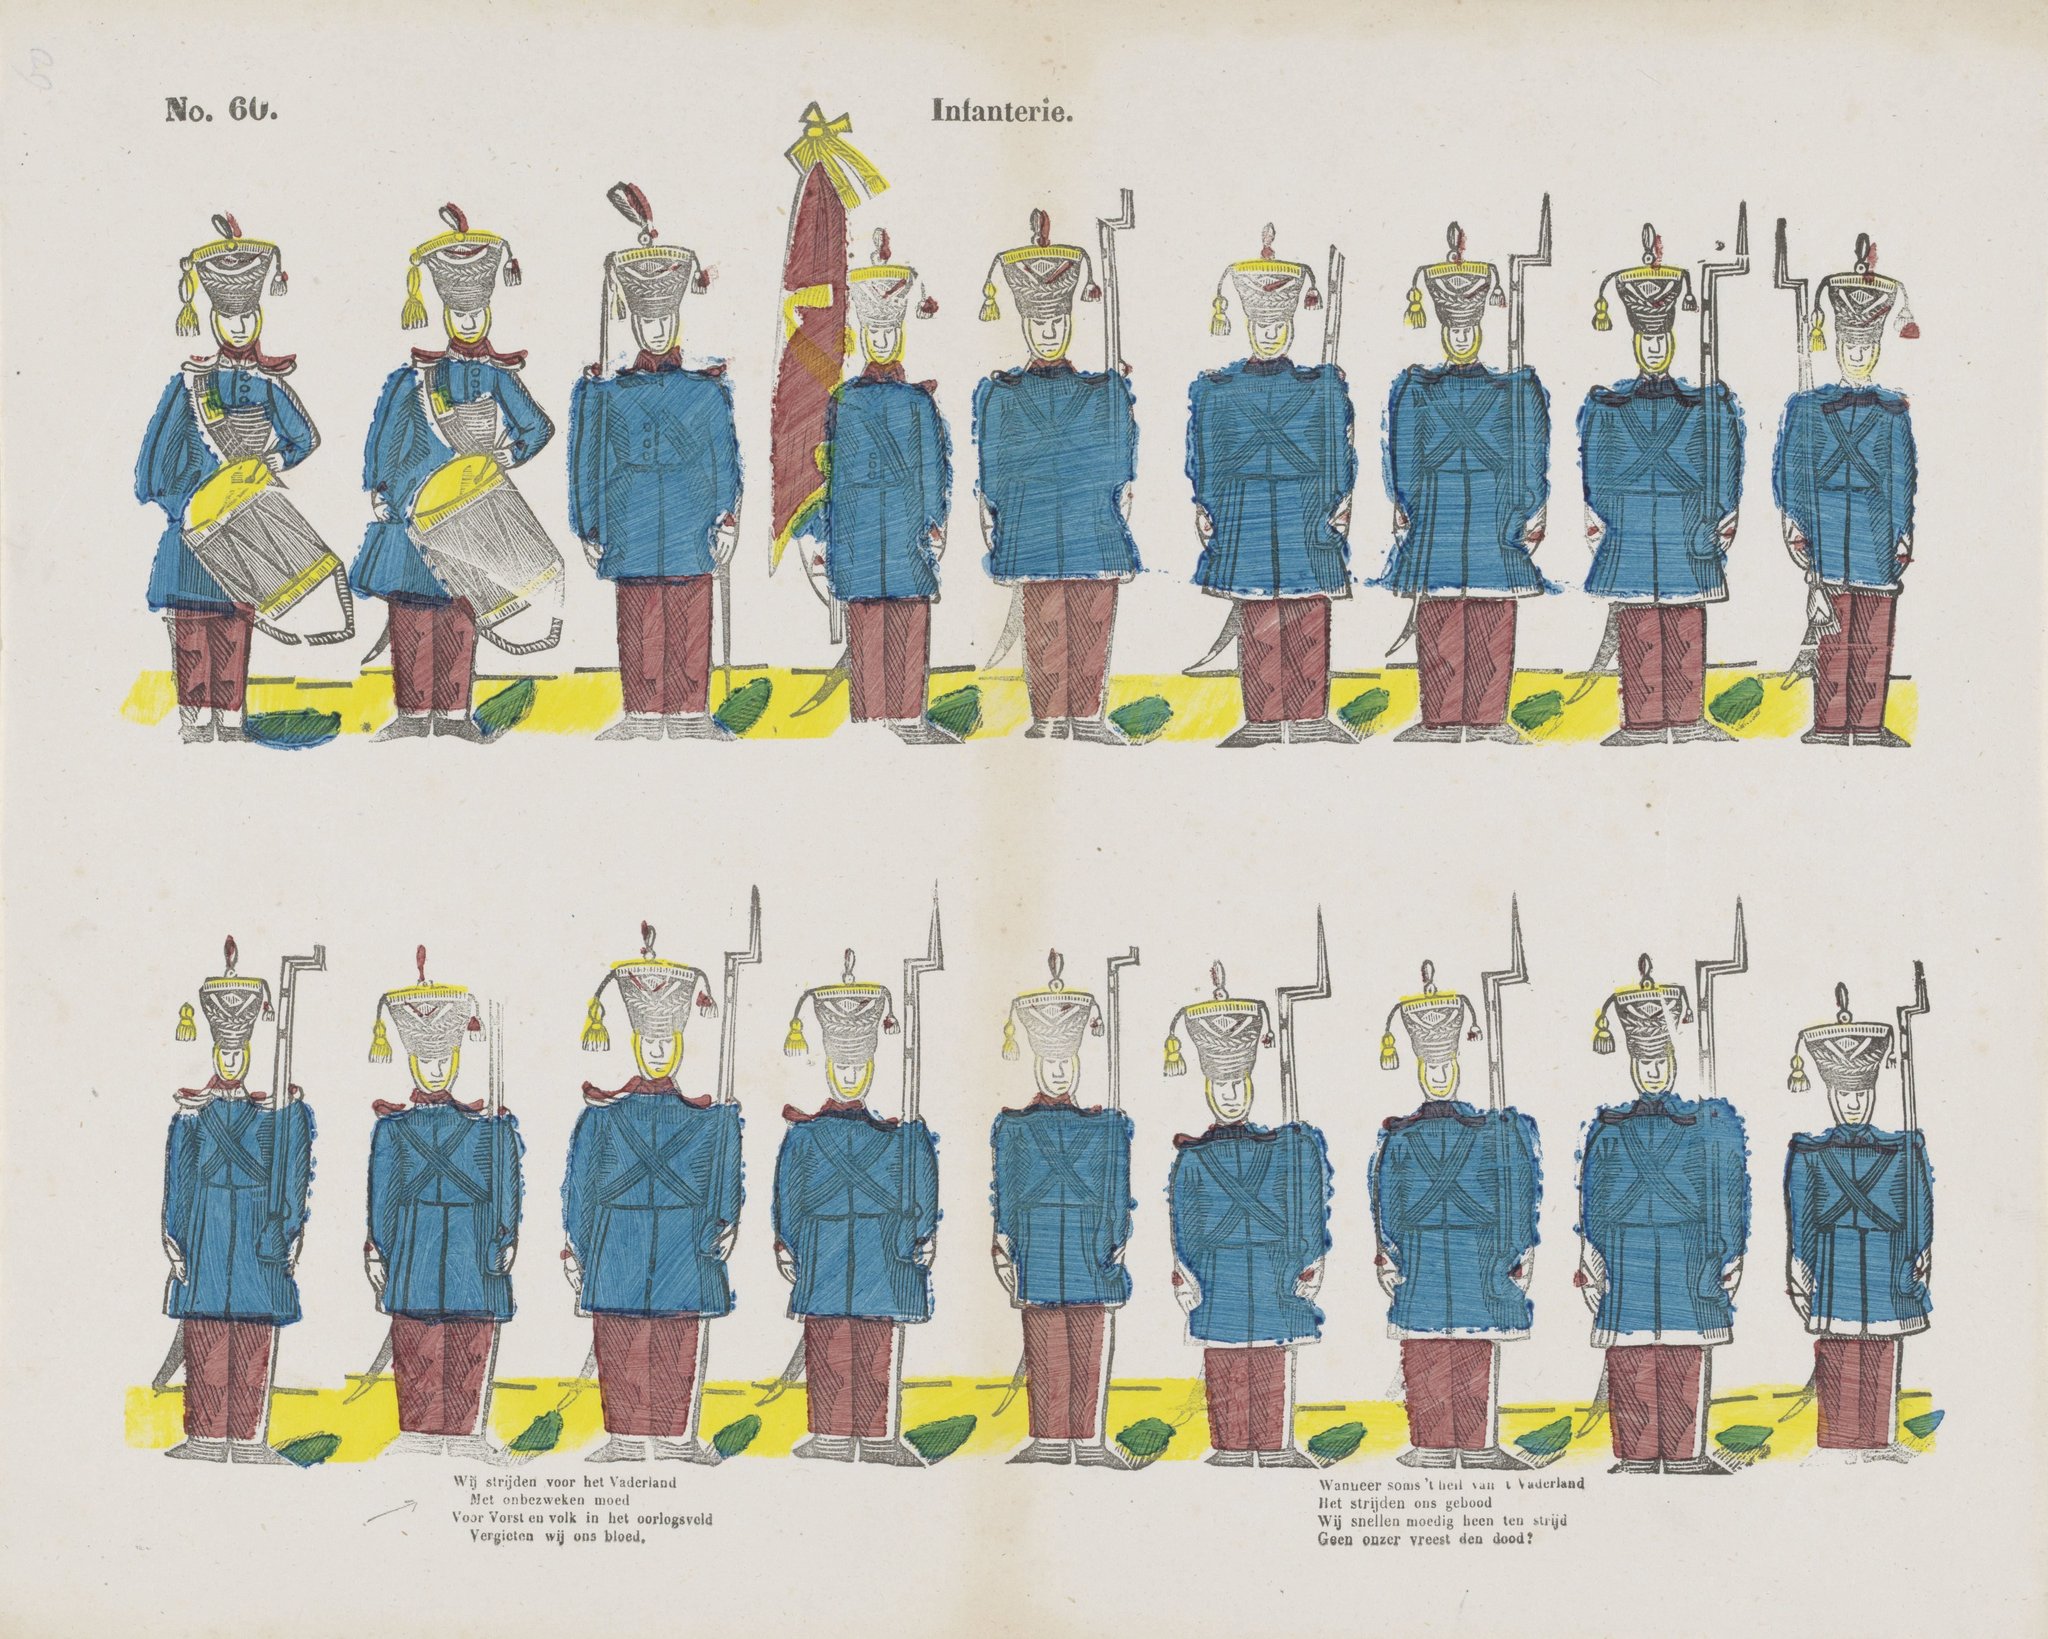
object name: print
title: Infanterie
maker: Anonymous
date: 1848-1881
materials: paper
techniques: colour, letterpress printing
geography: netherlands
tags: the soldier; the soldier's life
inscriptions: collector's mark: Lugt 2760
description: Blad met 2 horizontale rijen met voorstellingen van militairen. In de ondermarge een vers in twee kolommen. Genummerd linksboven: No. 60.